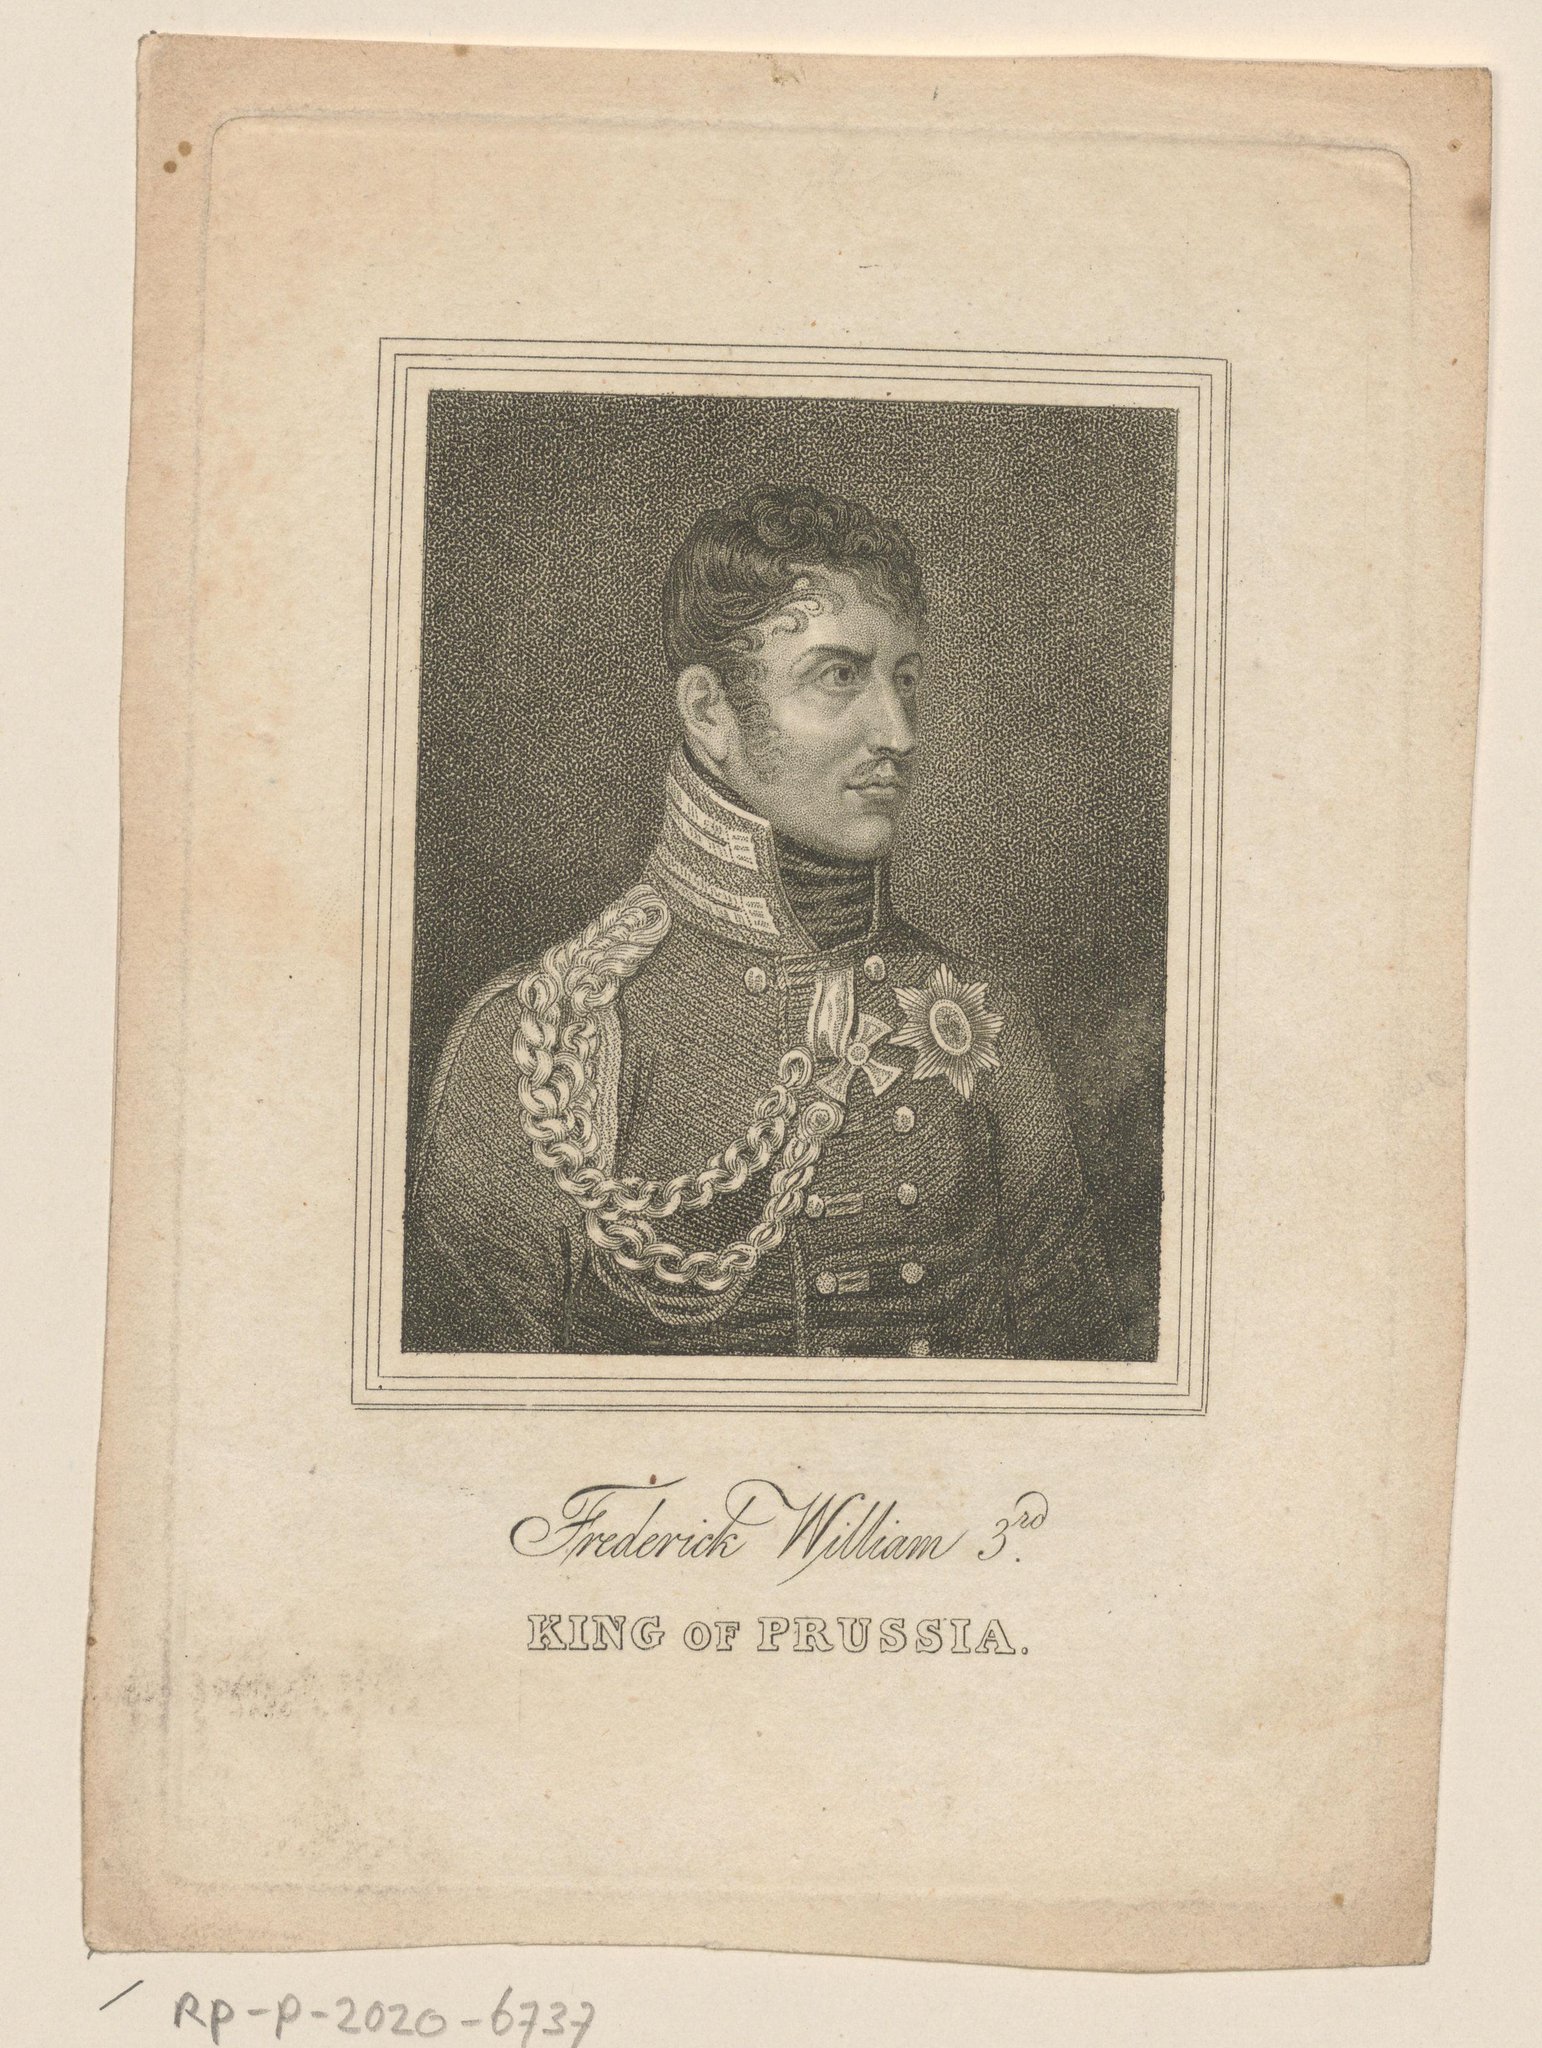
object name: print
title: Portret van Frederik Willem III van Pruisen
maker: Anonymous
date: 1797-1830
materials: paper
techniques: etching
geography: england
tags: berlin, frederik willem iii koning van pruisen, historical persons, (military) uniforms, king